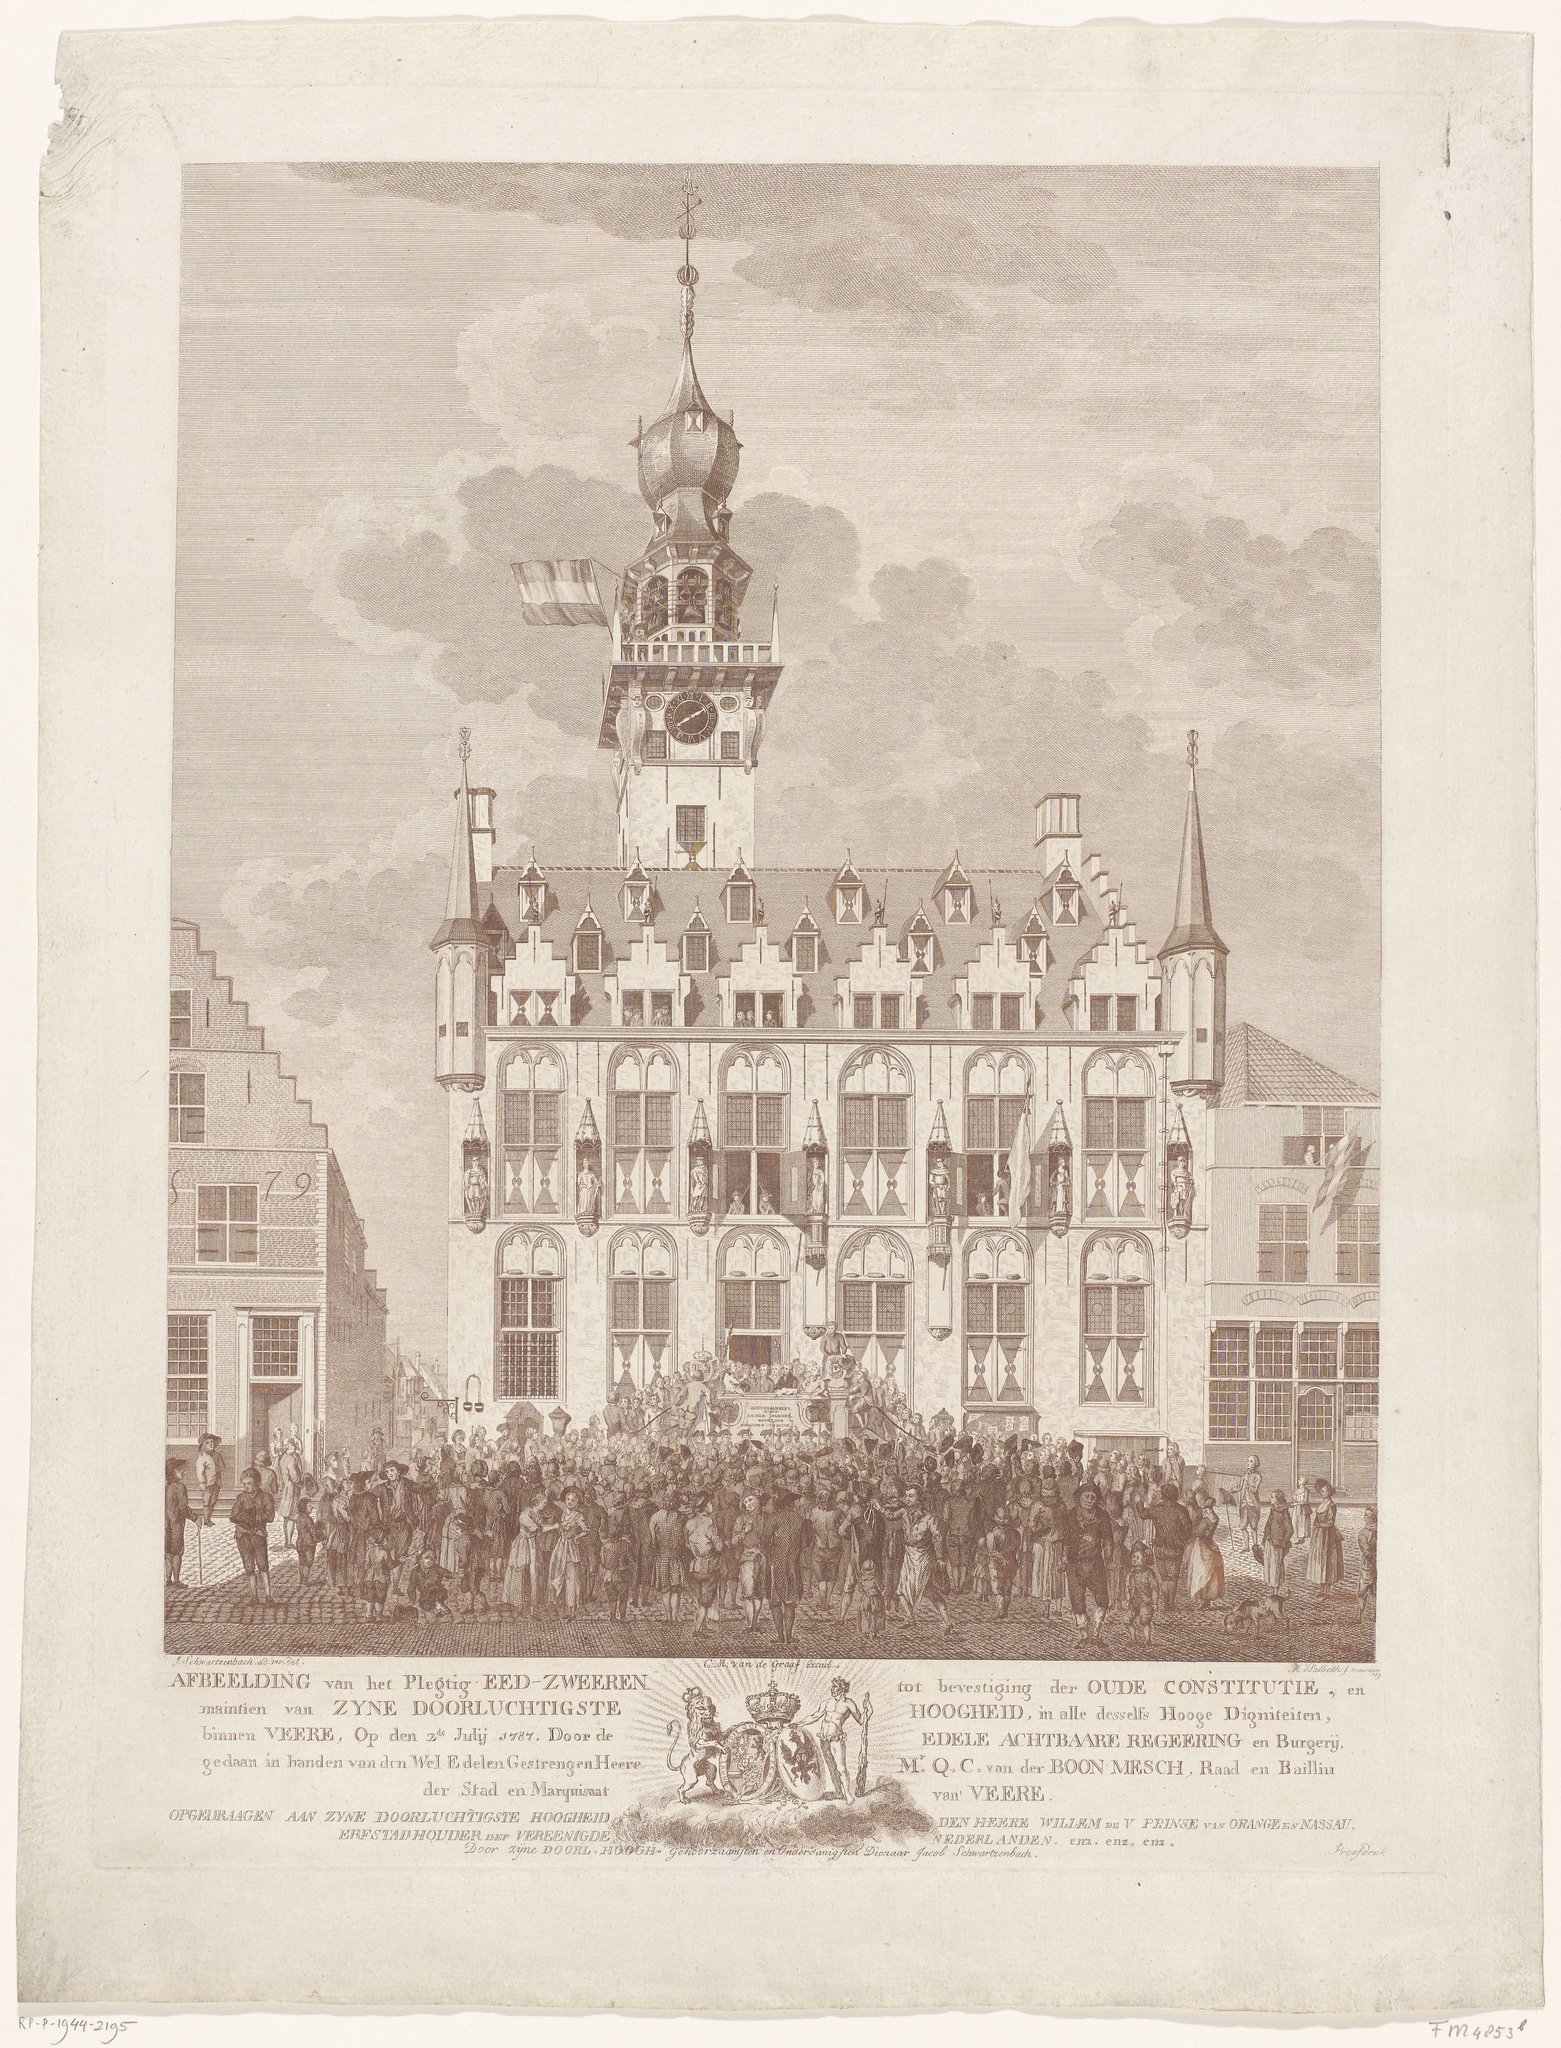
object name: print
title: Trouw zweren aan de stadhouder te Veere, 1787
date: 1789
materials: paper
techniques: engraving, etching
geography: veere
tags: the hague, william v (prince of orange), new ruler taking the oath, swearing an oath (with two fingers raised)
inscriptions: collector's mark: Lugt 2228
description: Op de trappen van het stadhuis zweren het stadsbestuur en de burgerij trouw aan de stadhouder Willem V en aan de oude grondwet, 2 juli 1787.